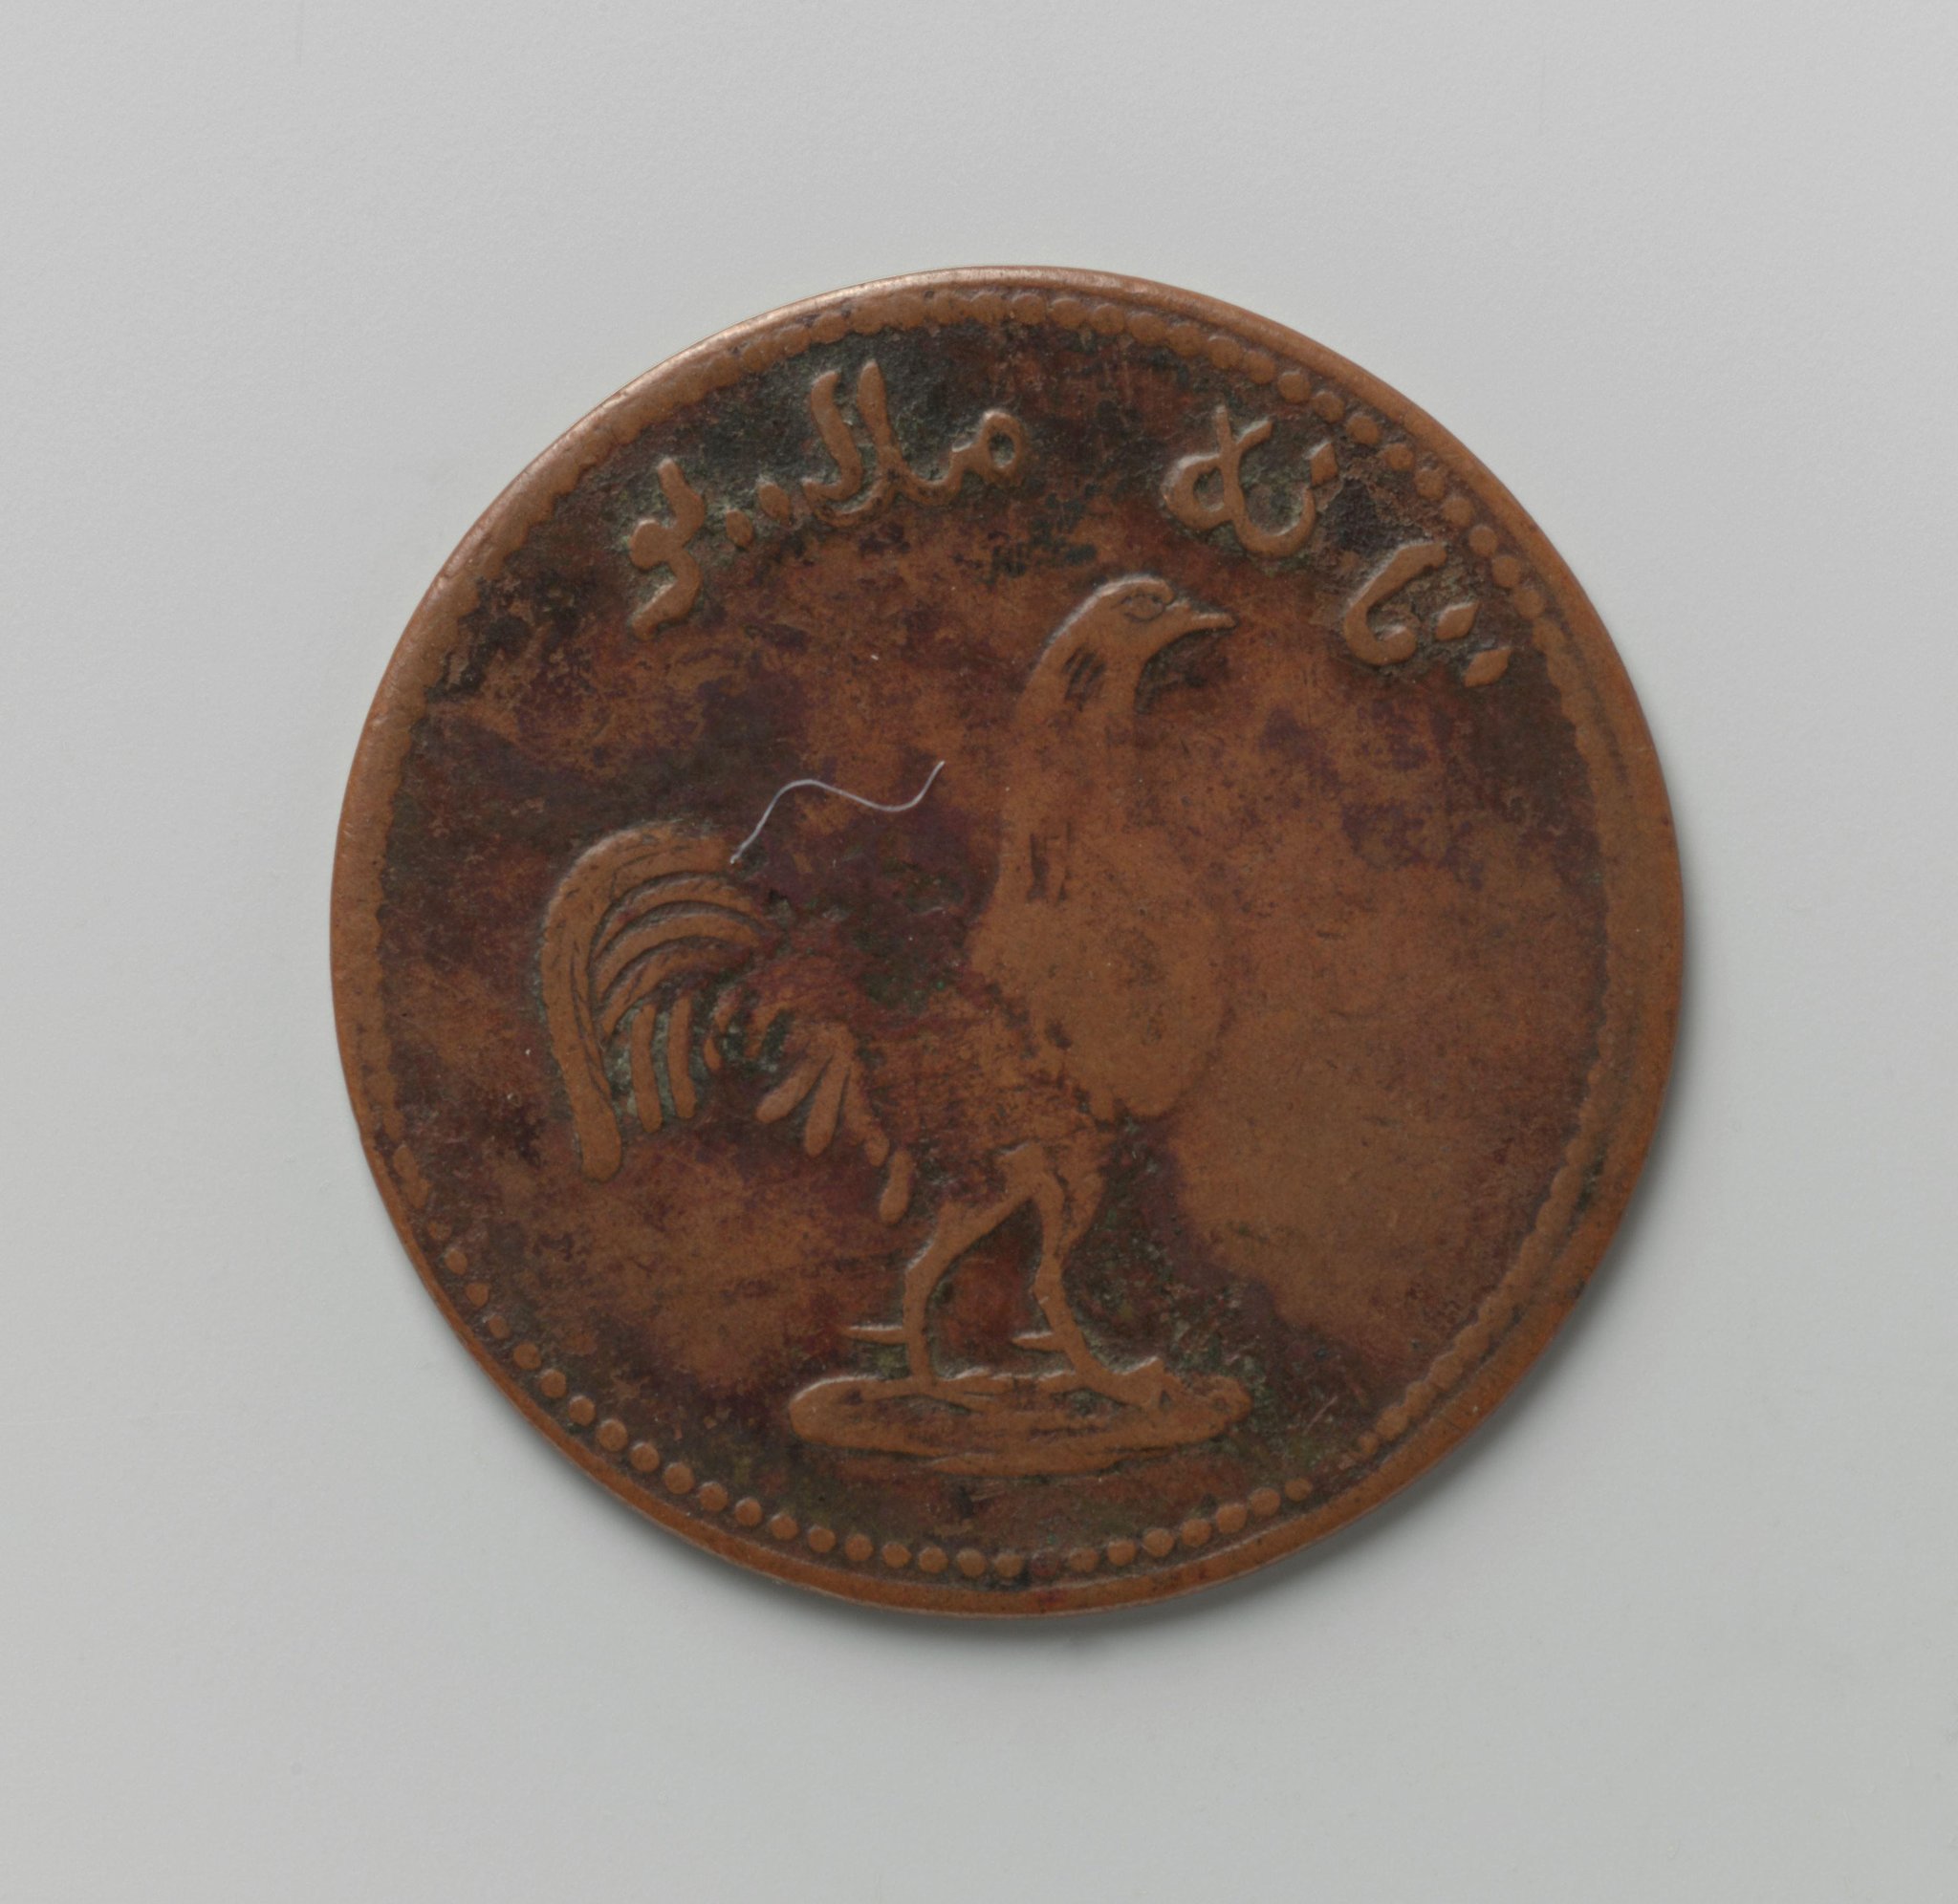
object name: coin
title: Haantjesduit voor Malakka en Sumatra ten behoeve van Boeginezen, 1834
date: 1834-1835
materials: copper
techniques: striking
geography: birmingham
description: Koperen munt. Particuliere munt. Voorzijde: haan naar rechts, waarboven aanduiding in het Maleis in Arabische lettertekens: Land van de Maleiers. Keerzijde: een 16-bladige rozet, waaronder het jaartal 1250 in Islamitische tijdsrekeningen waaromheen omschrift in het Boeginees. Gladde rand.